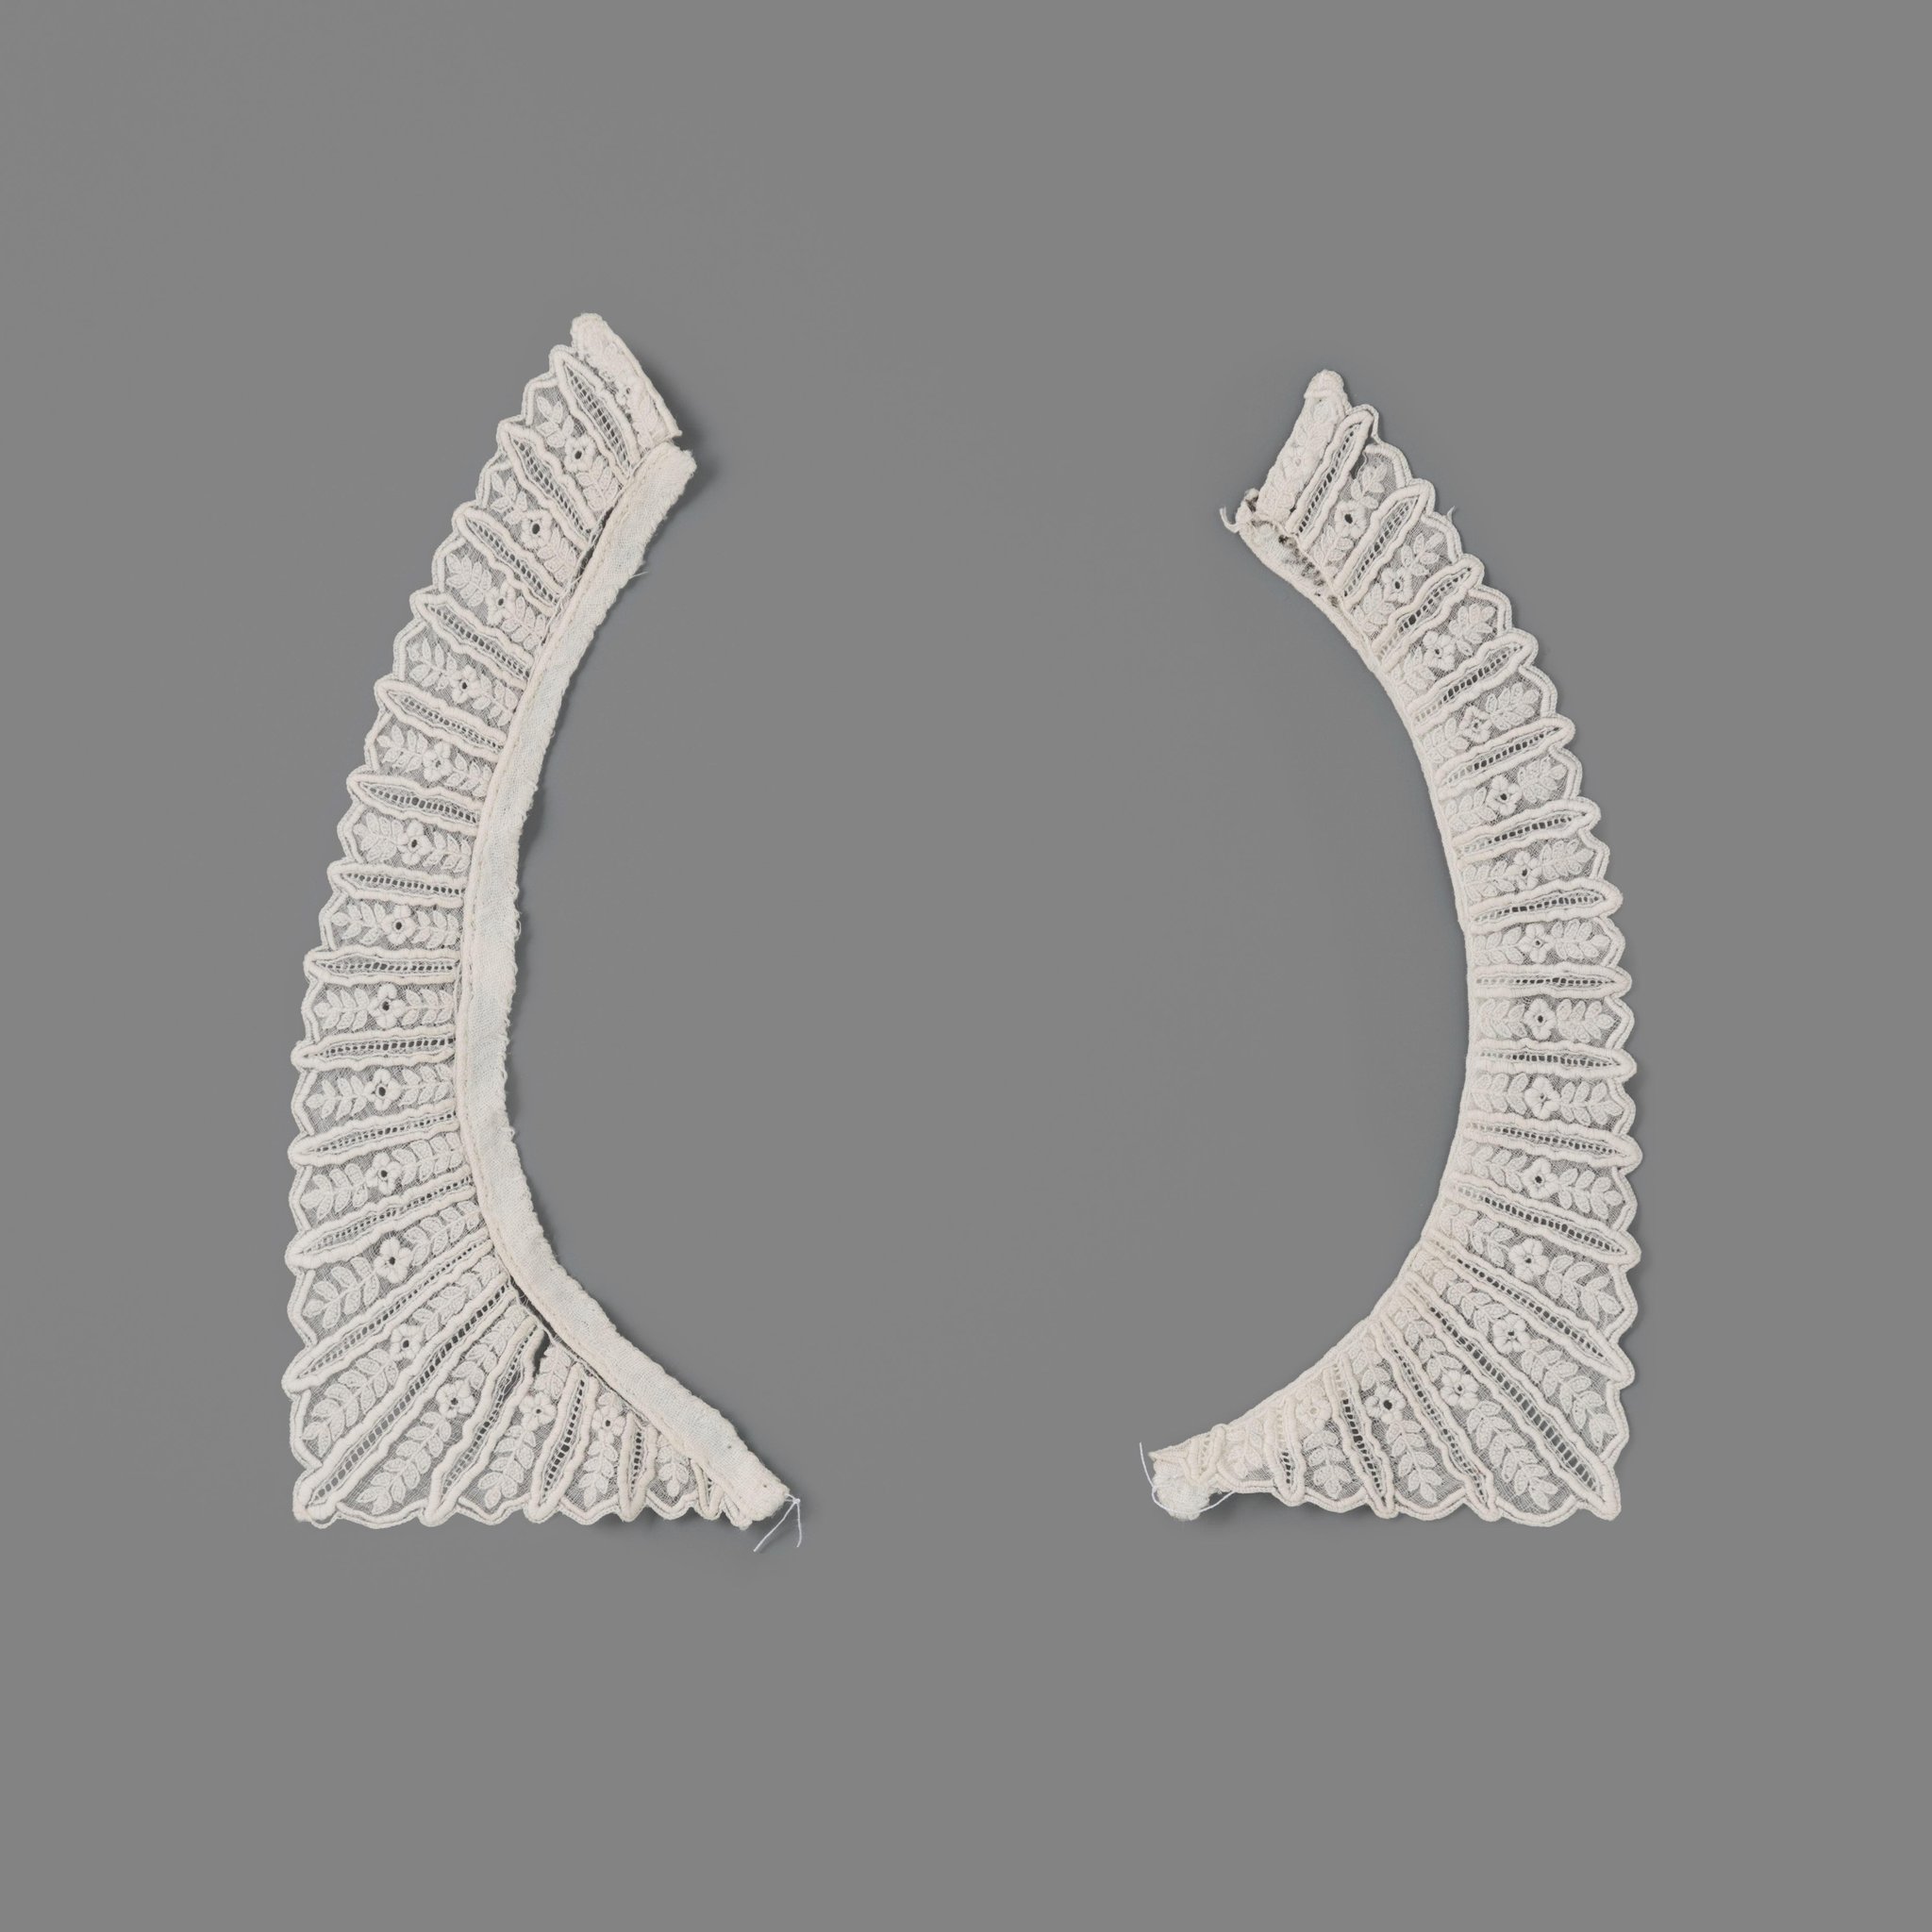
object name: collar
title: Kraag met witwerk tussen godrons in ajour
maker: Anonymous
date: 1850-1870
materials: linen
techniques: embroidery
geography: switzerland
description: Kraagje van wit borduurwerk; plumetisborduursel. Model. Klein, rond, liggend model, met verbrede vierkante hoeken en smallere uiteranden. Met wit biesje afgewerkt, waarin een koordje. Patroon. Straalsgewijs staande bloemtakjes, met één roosje in het midden tussen godrons met ajourwerk.